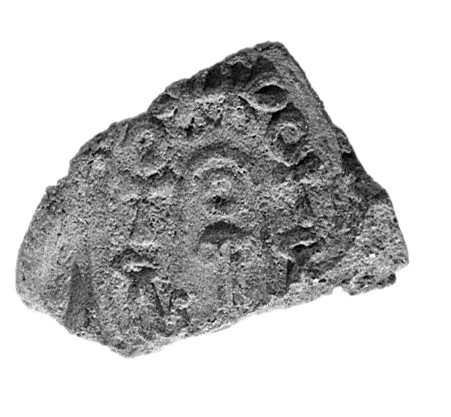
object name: sealing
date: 1981-1640 BCE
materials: mud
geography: egypt